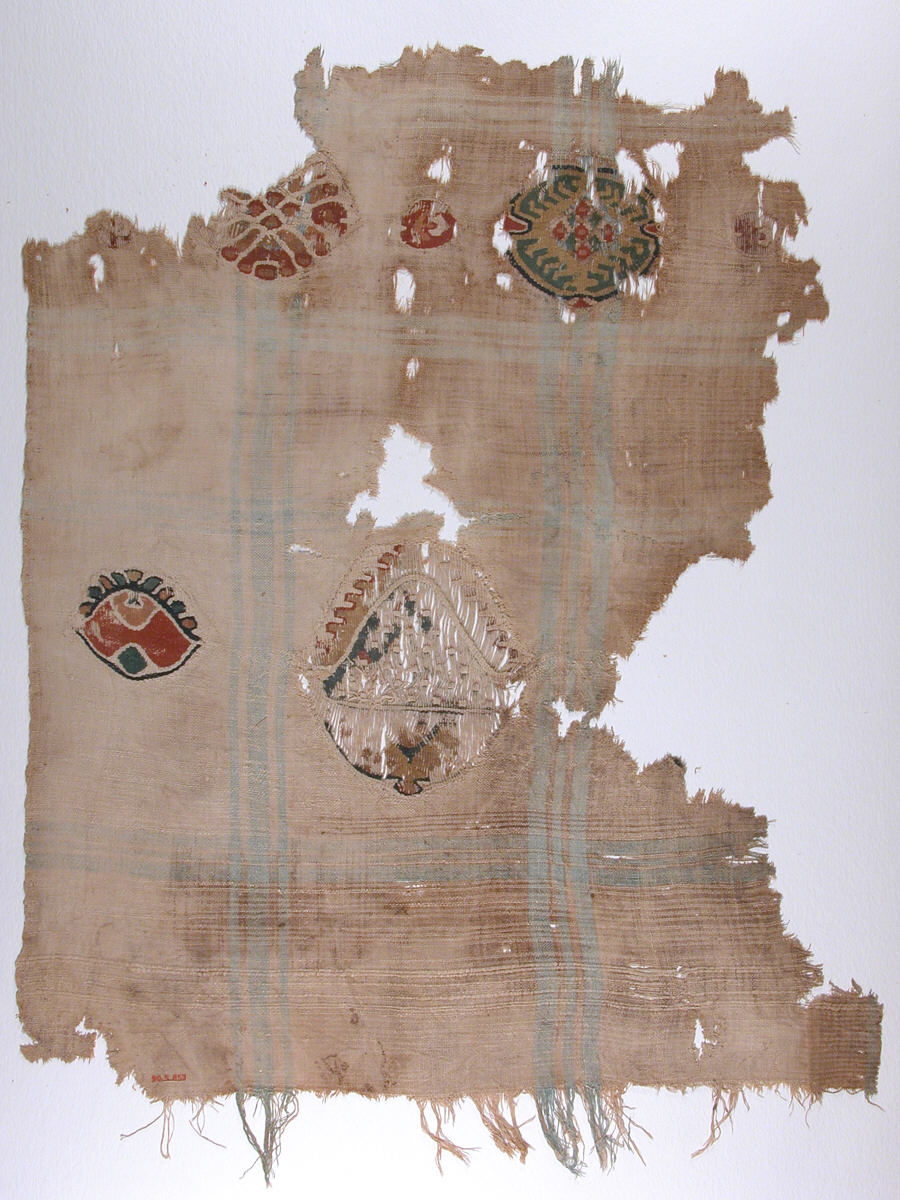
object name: textile fragment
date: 401-500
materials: linen, wool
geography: egypt